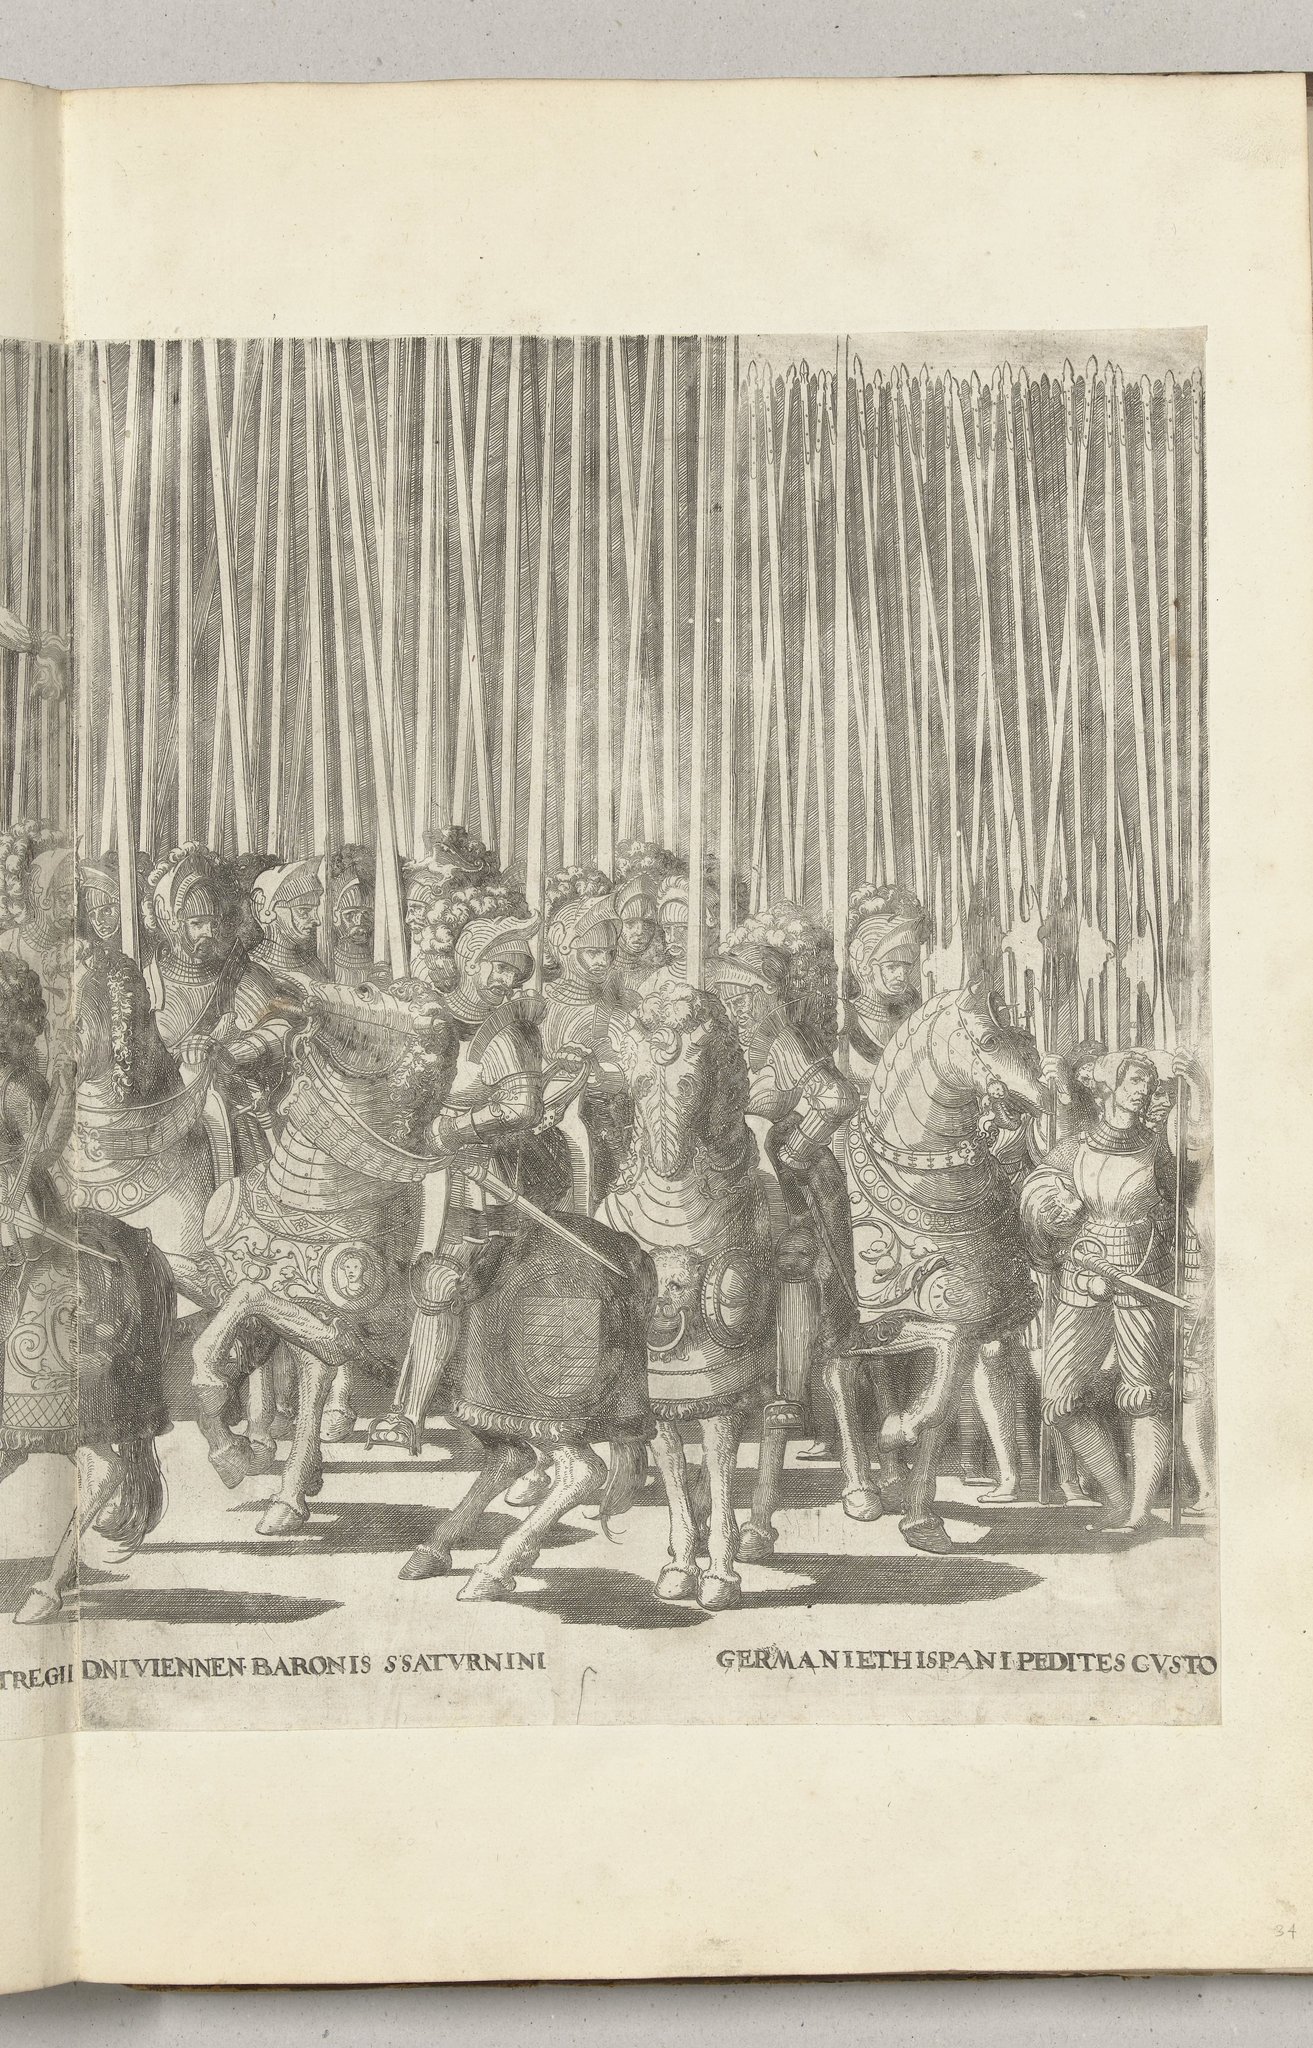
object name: print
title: Landsknechten, plaat [LL]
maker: nicolaas hogenberg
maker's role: draughtsman, painter, print maker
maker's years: 1500-1539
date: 1530-1536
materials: paper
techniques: etching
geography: mechelen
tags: ghent, charles v (holy roman emperor and king of spain), festivities (+ parade, pageant, cavalcade ~ festive activities)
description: Prent in het album waarin zijn ingeplakt de 40 platen die achterelkaar samen het fries vormen van de optocht van Karel V met de paus Clemens VII te Bologna na zijn kroning tot keizer, 24 februari 1530.